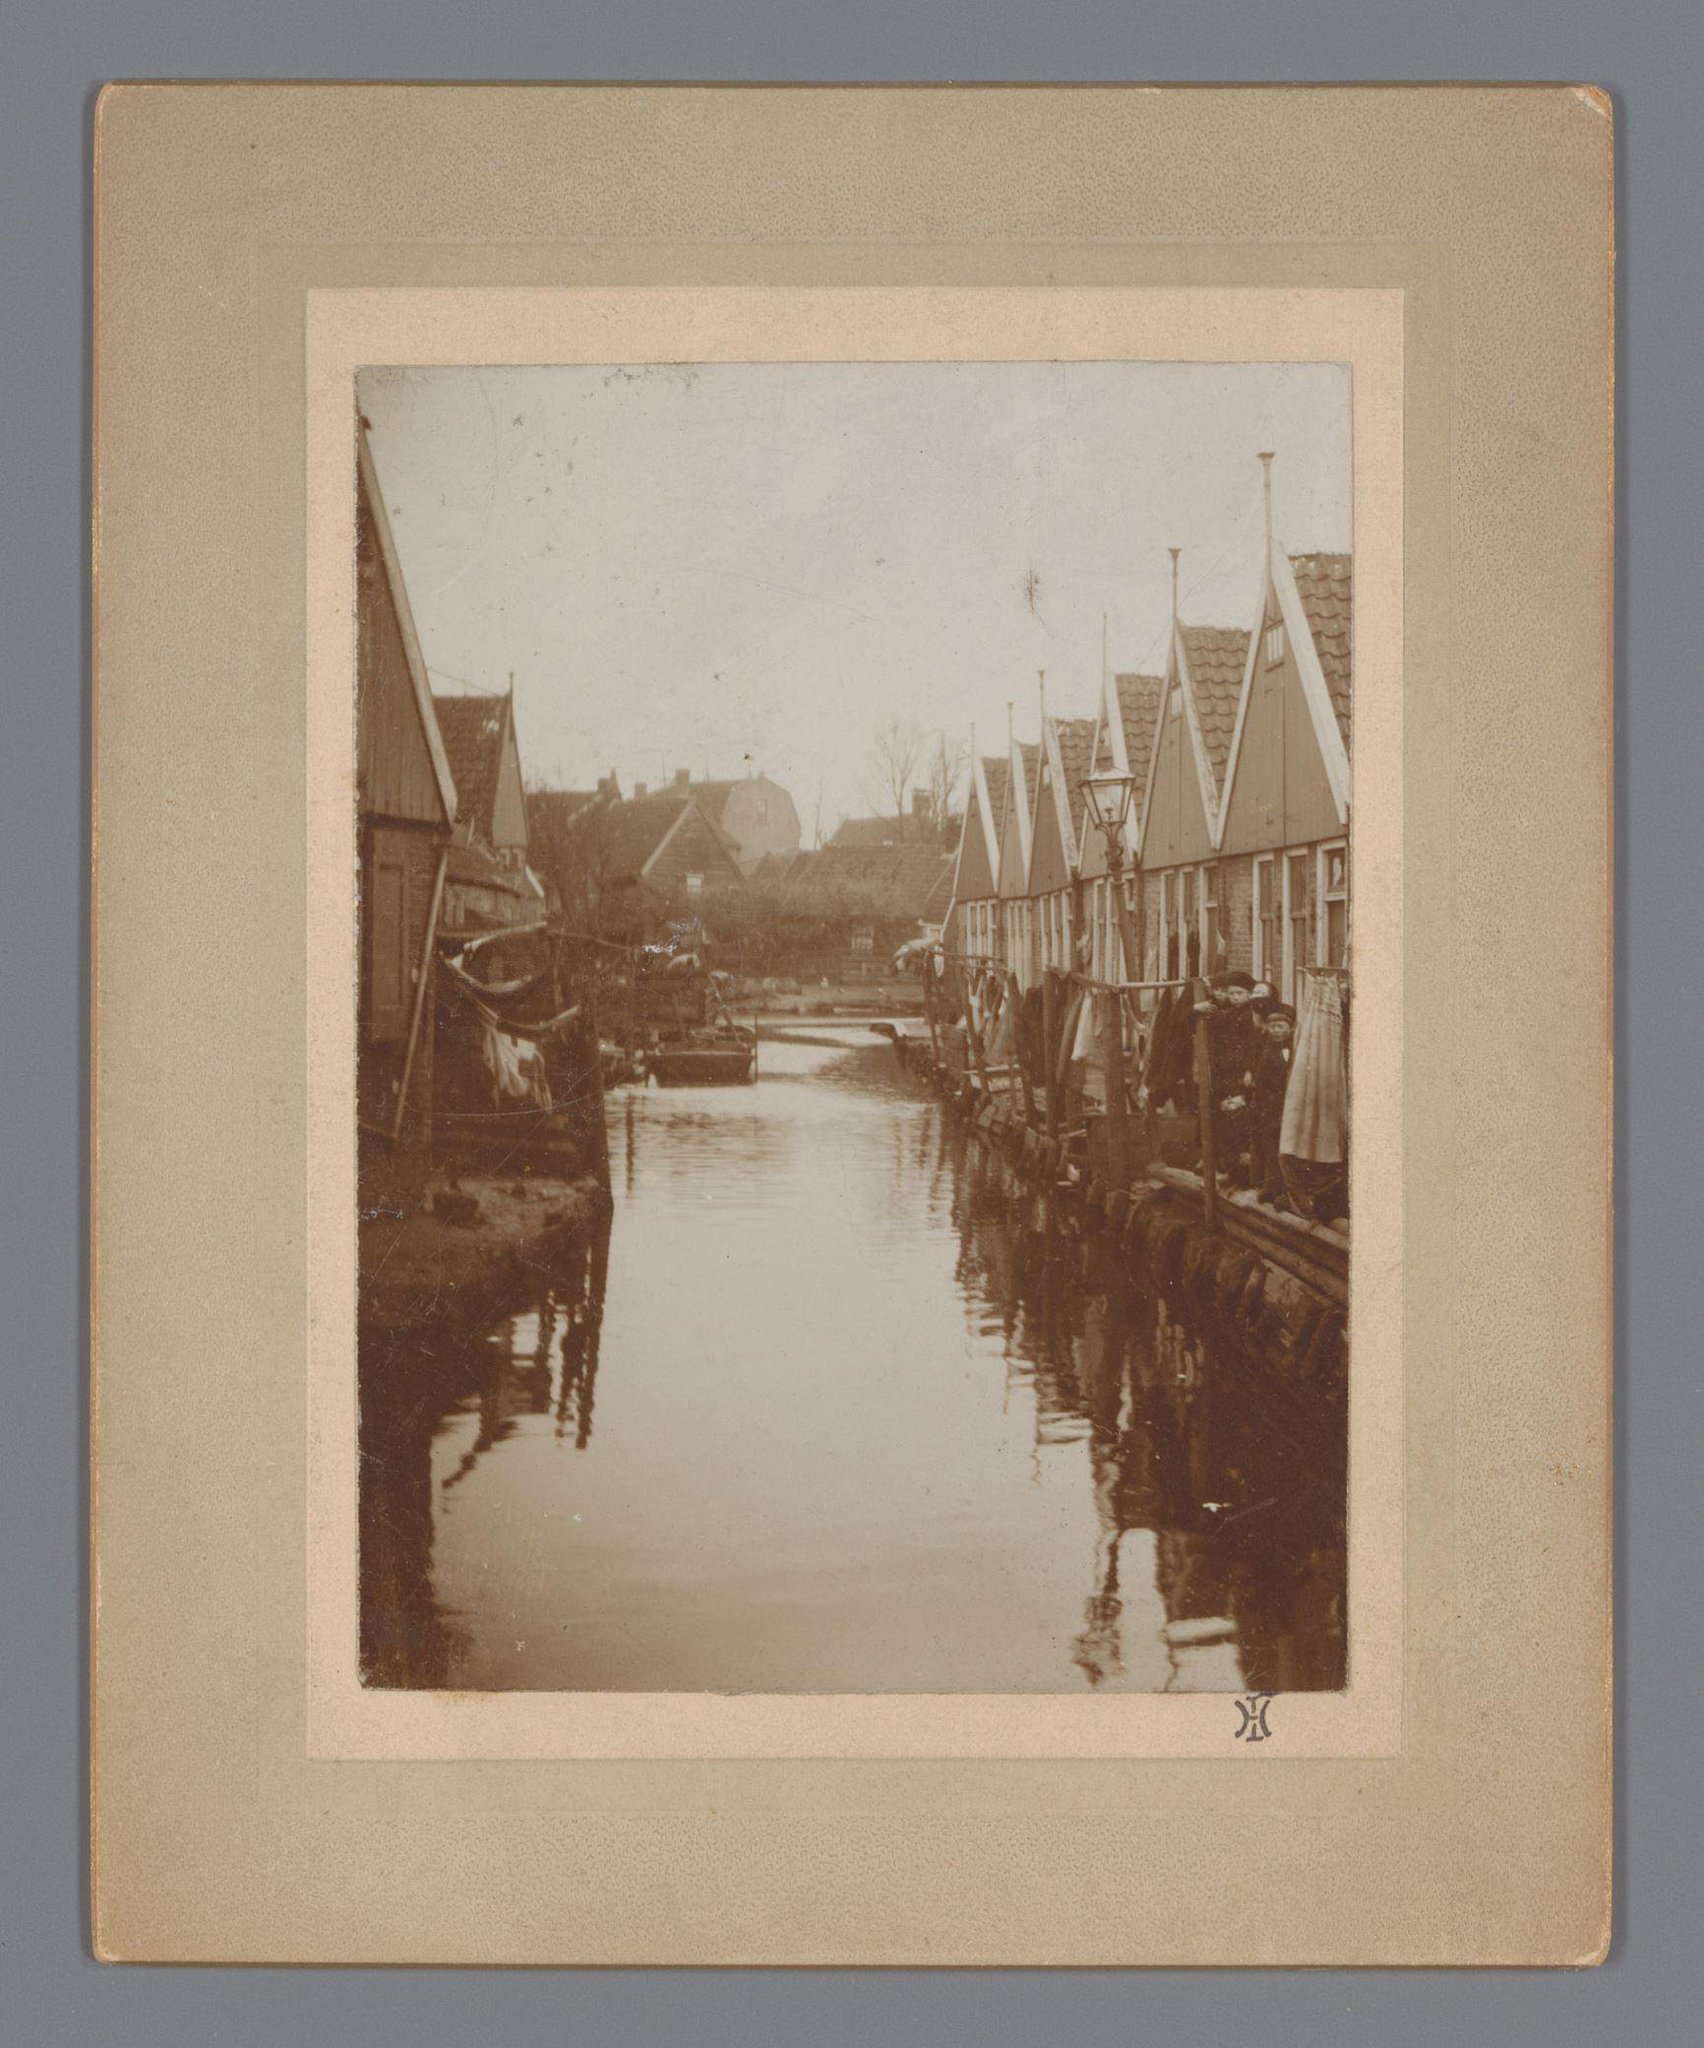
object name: photograph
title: Gezicht op woningen aan het water te Volendam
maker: Anonymous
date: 1875-1920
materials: cardboard, photographic support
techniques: collodion silver print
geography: volendam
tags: village, housing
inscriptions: annotation: ‘Buntje te Volendam’, monogram: ‘[HI]’